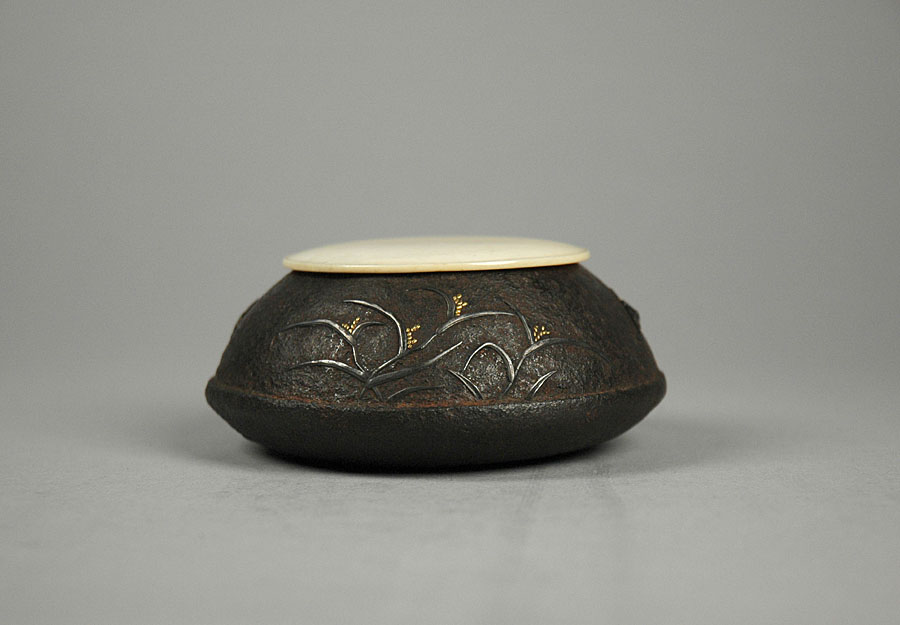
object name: box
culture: japanese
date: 1701-1800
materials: iron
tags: leaves